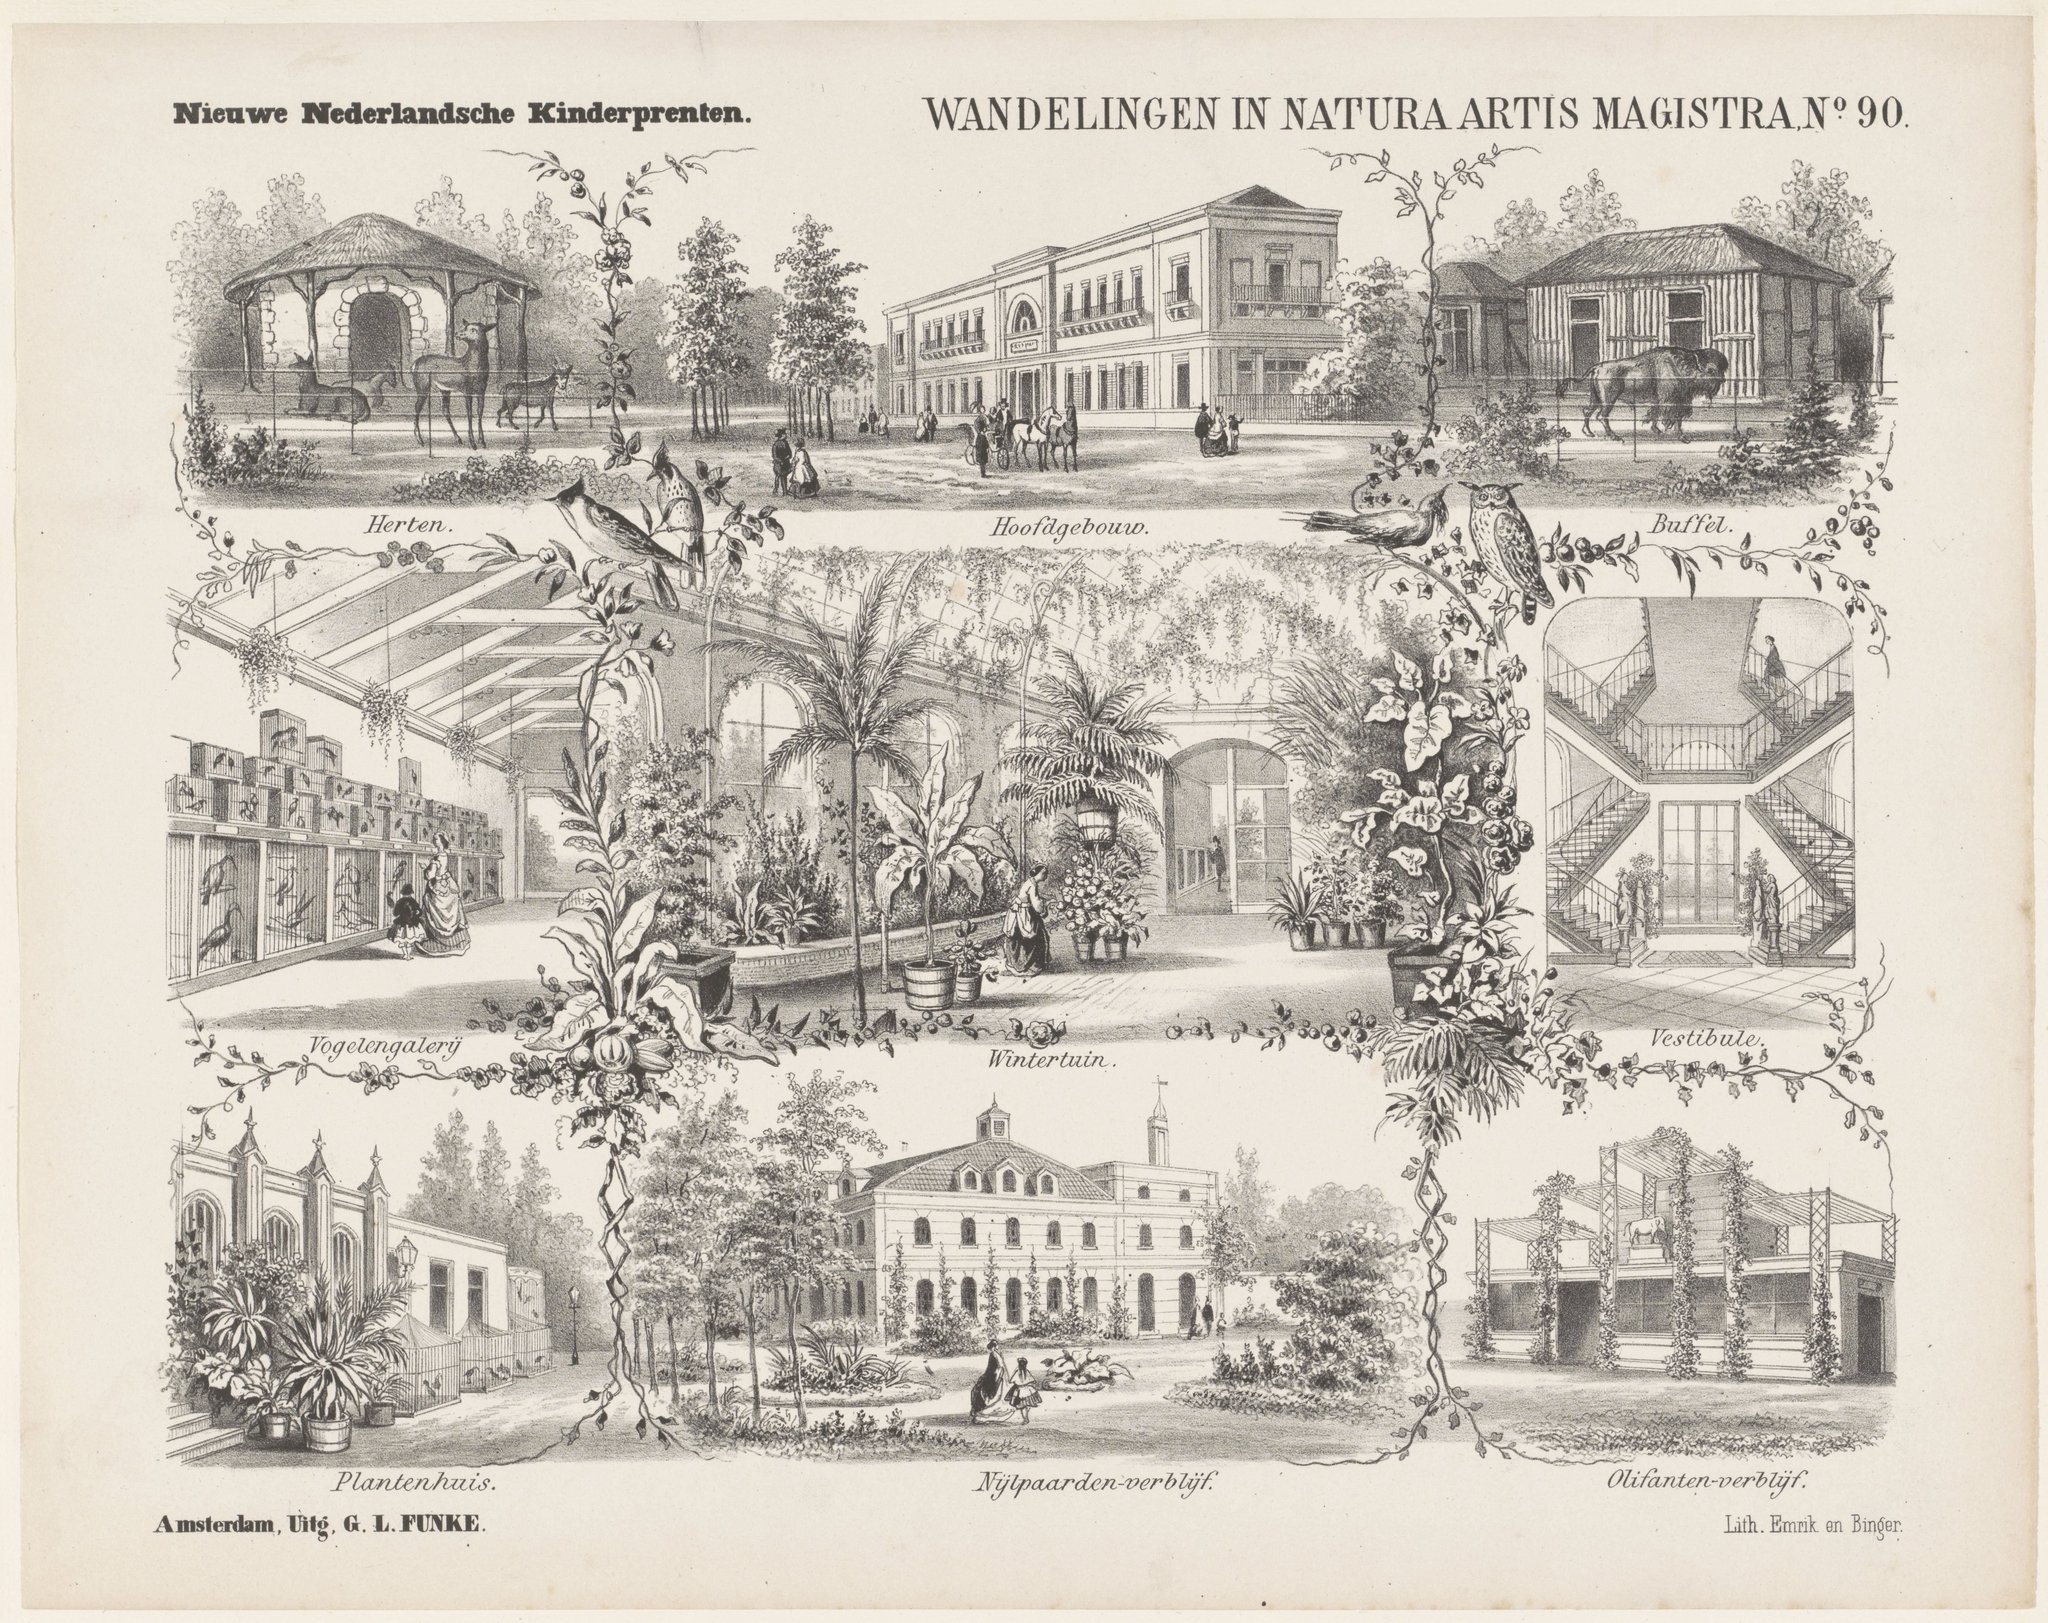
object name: print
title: Nieuwe Nederlandsche kinderprenten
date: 1865-1875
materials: paper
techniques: letterpress printing, lithograph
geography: haarlem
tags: zoological garden, zoo, seen as place where non-domestic animals are kept, zoo (as place of recreation)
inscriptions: collector's mark: Lugt 2760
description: Blad met 9 voorstellingen van gebouwen en dierenverblijven in de dierentuin Natura Artis Magistra, waaronder voorstellingen van het hoofdgebouw, de wintertuin en het nijlpaardenverblijf. Onder elke afbeelding een onderschrift. Genummerd rechtsboven: No. 90.